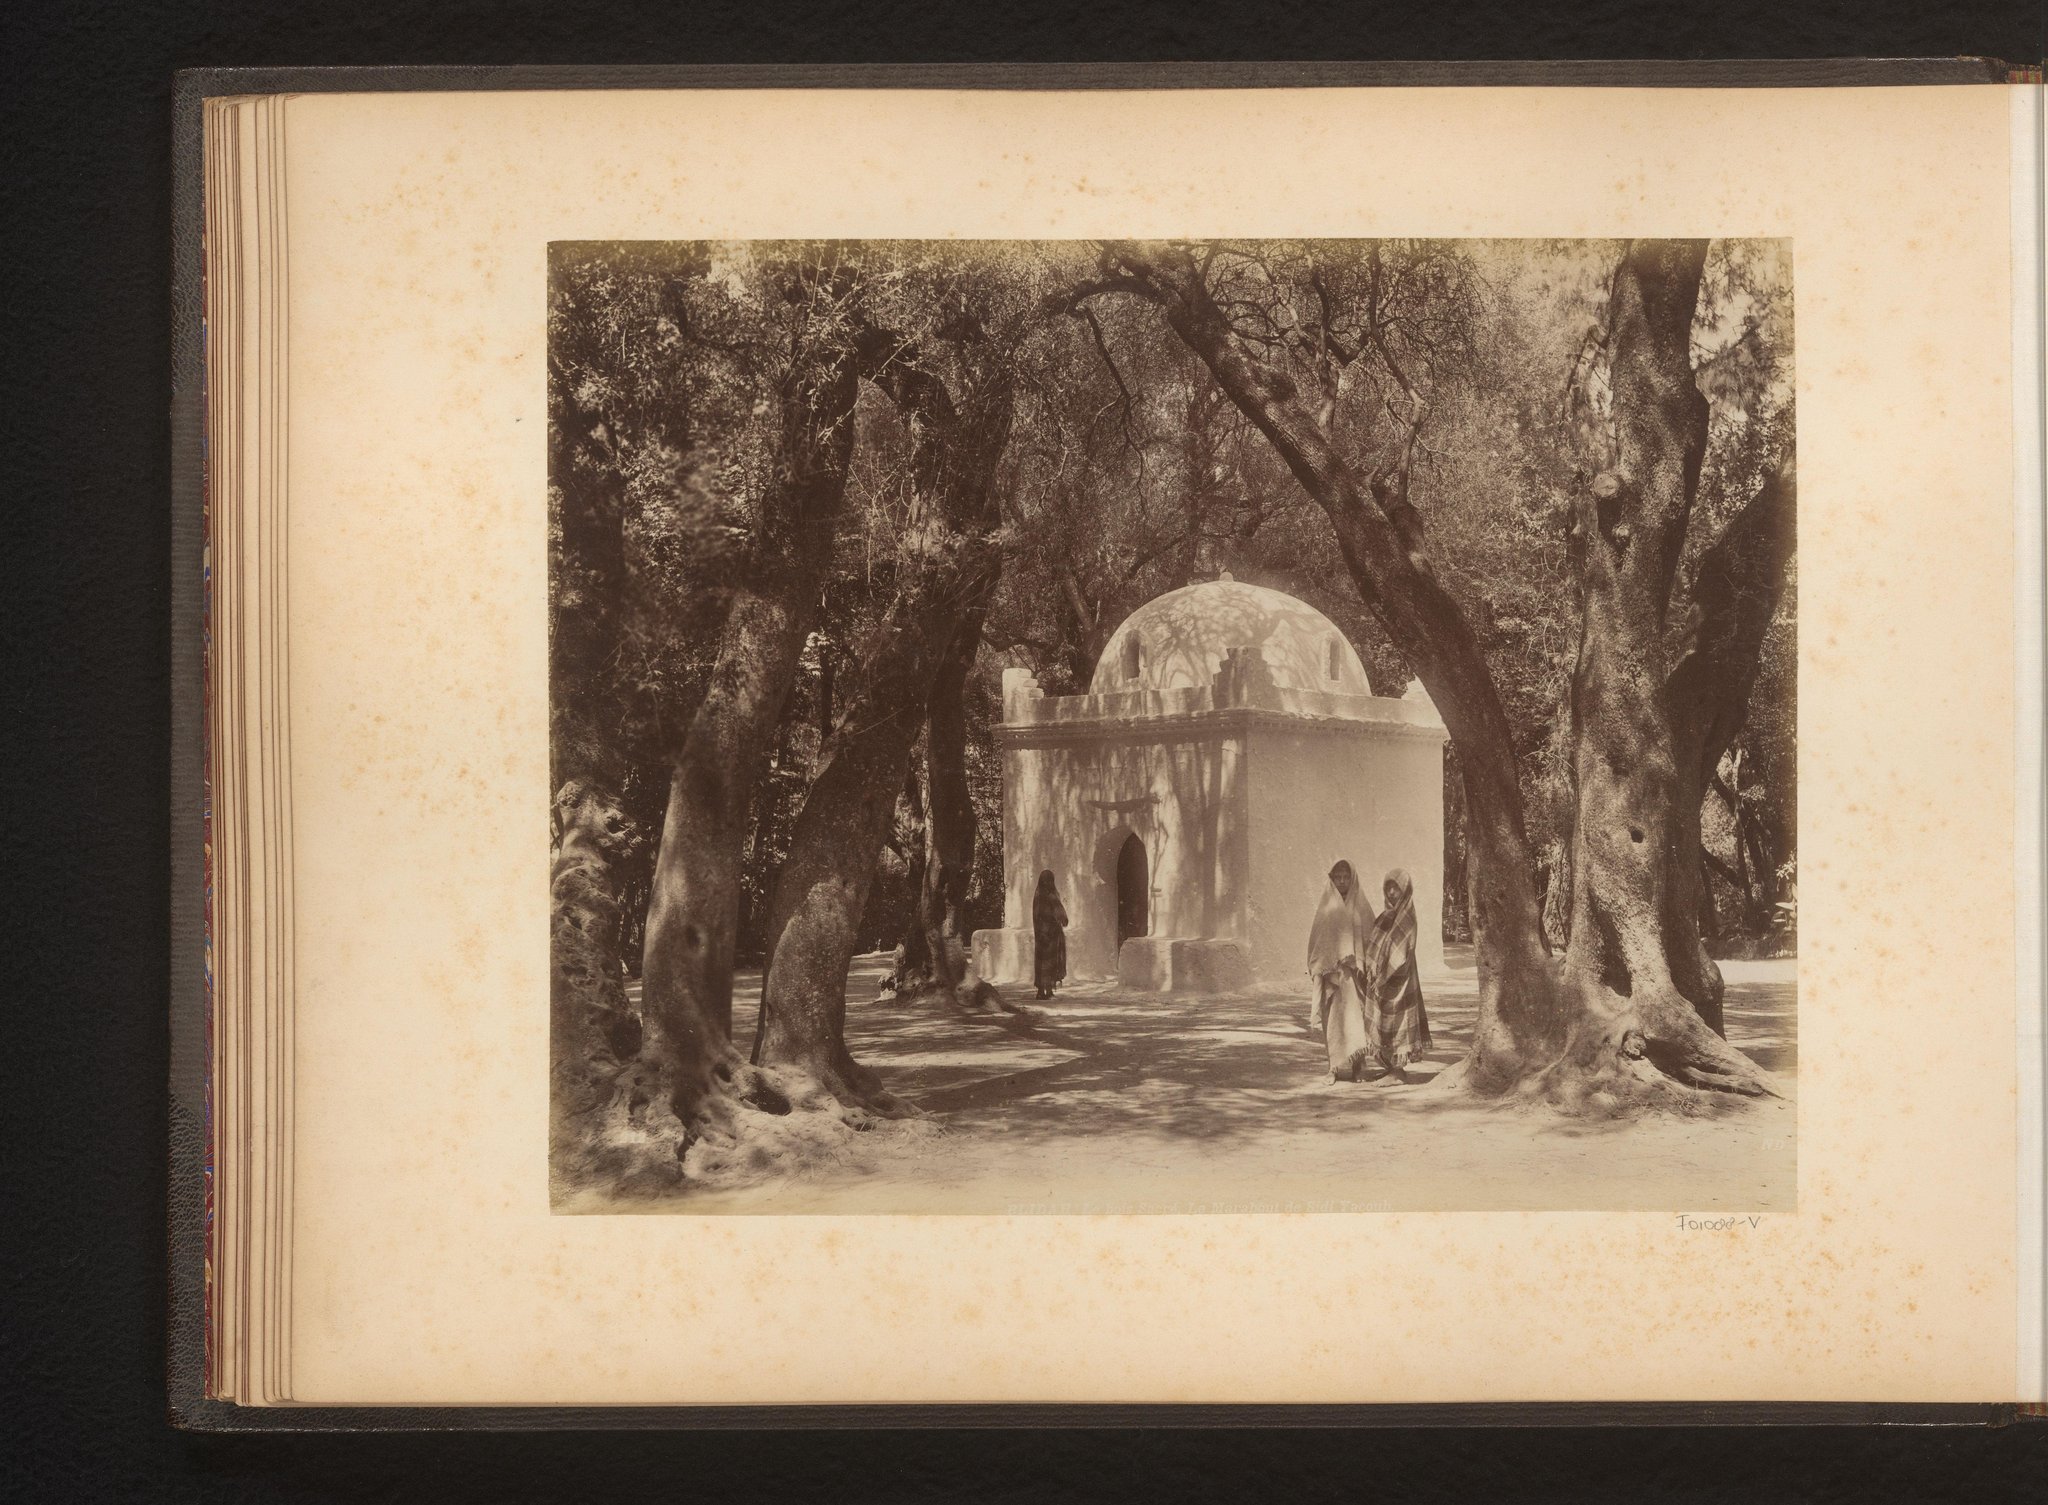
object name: photograph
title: Blidah. Le bois Sacre. Le Marabout de Sidi Yacoub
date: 1880-1900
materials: photographic support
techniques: albumen print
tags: el boulaïda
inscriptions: check stamp: ‘J. Kuhn Editeur/ 220 Rue de Rivoli Paris’